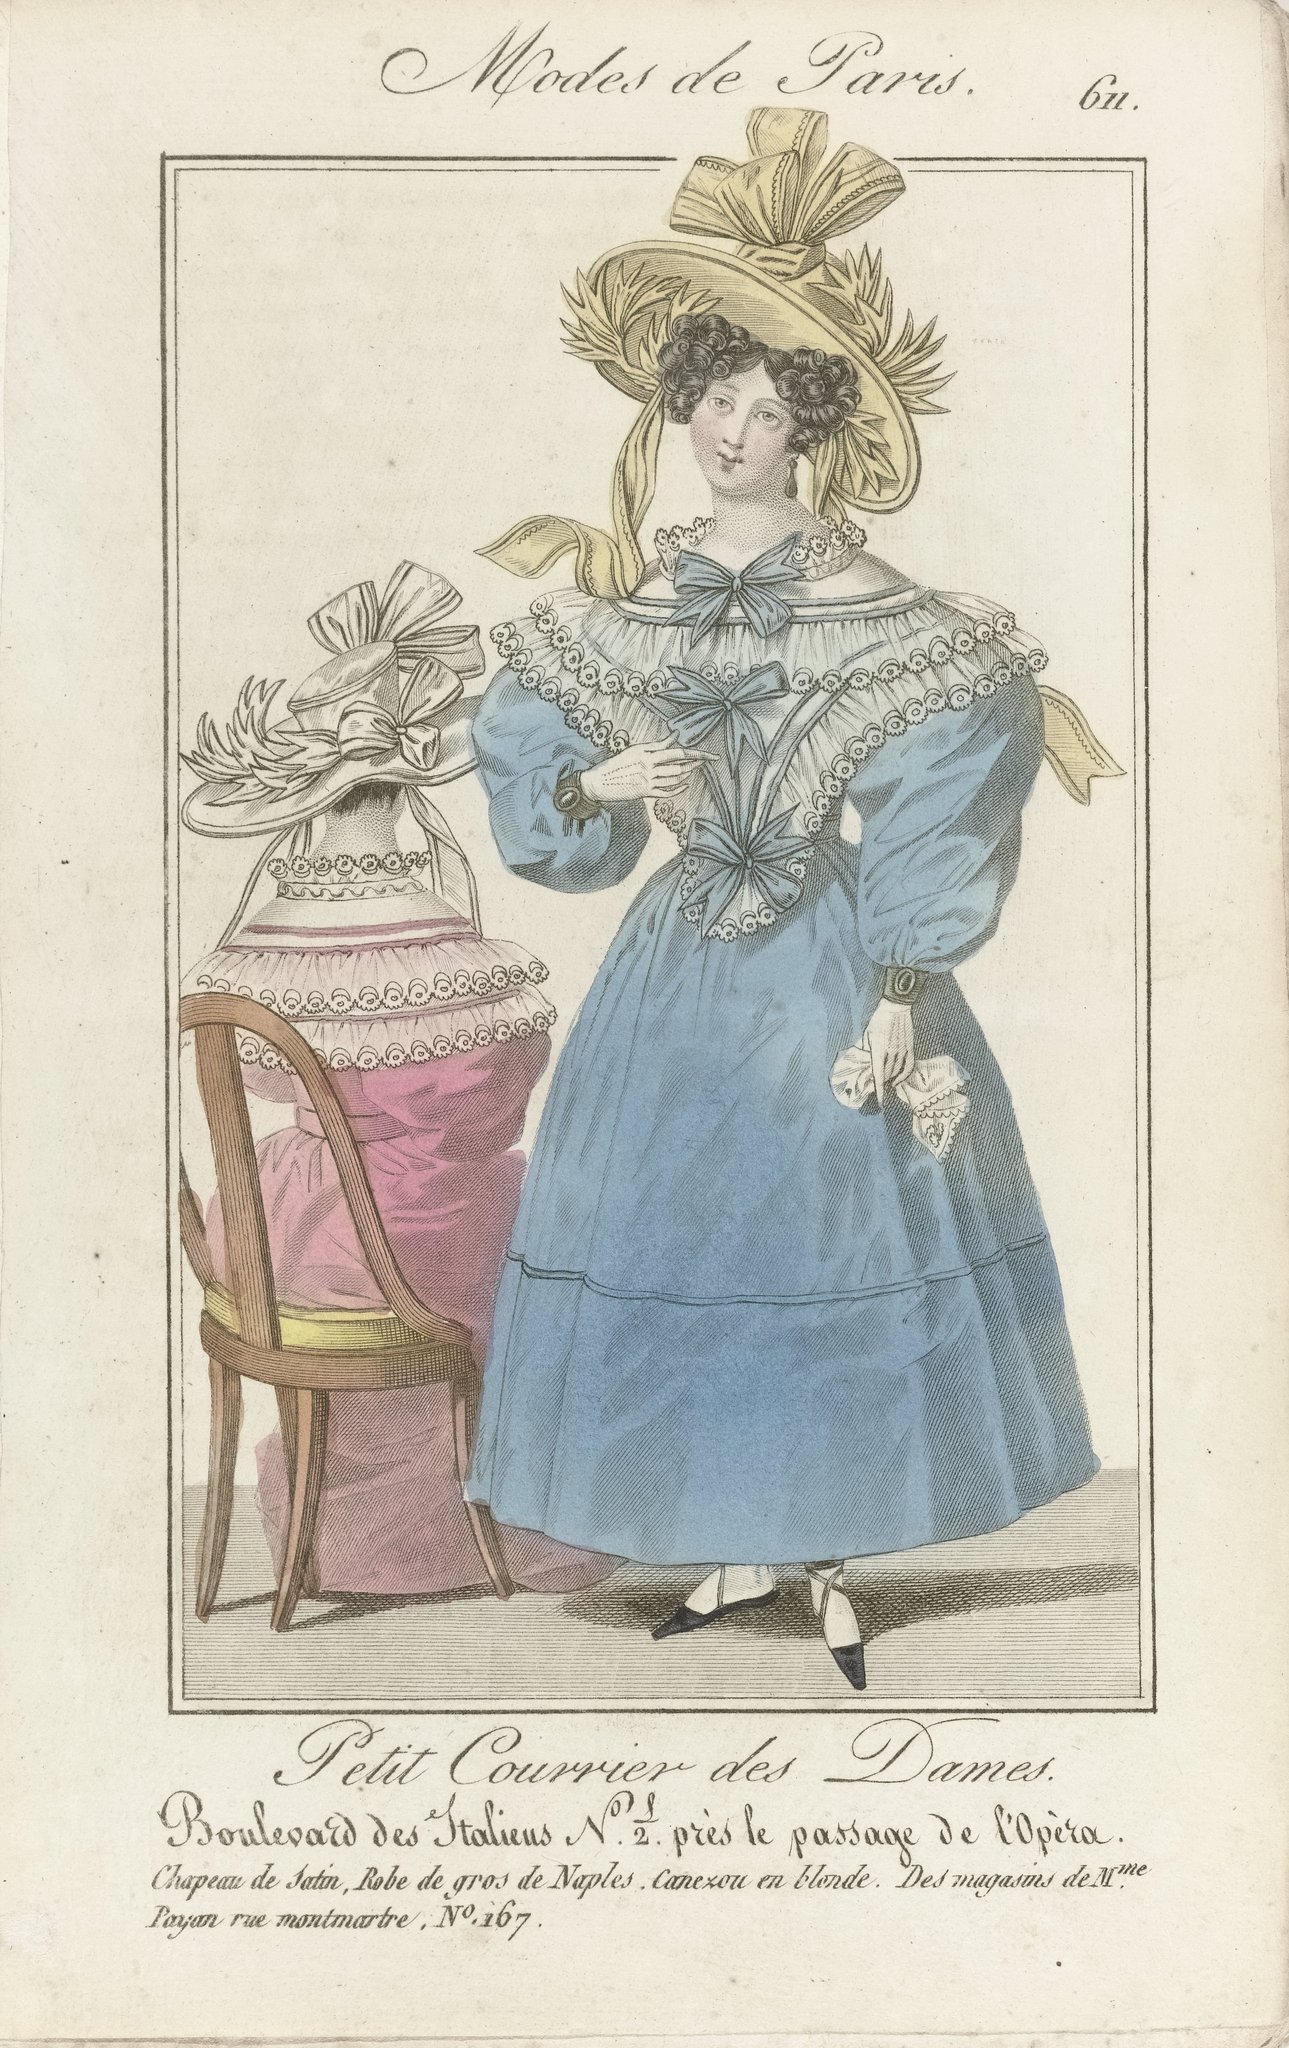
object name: magazine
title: Petit Courrier des Dames, 1828 (611)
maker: Anonymous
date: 1828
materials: paper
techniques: engraving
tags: fashion plates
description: Prent uit het modetijdschrift Petit Courrier des Dames (1821-1868).